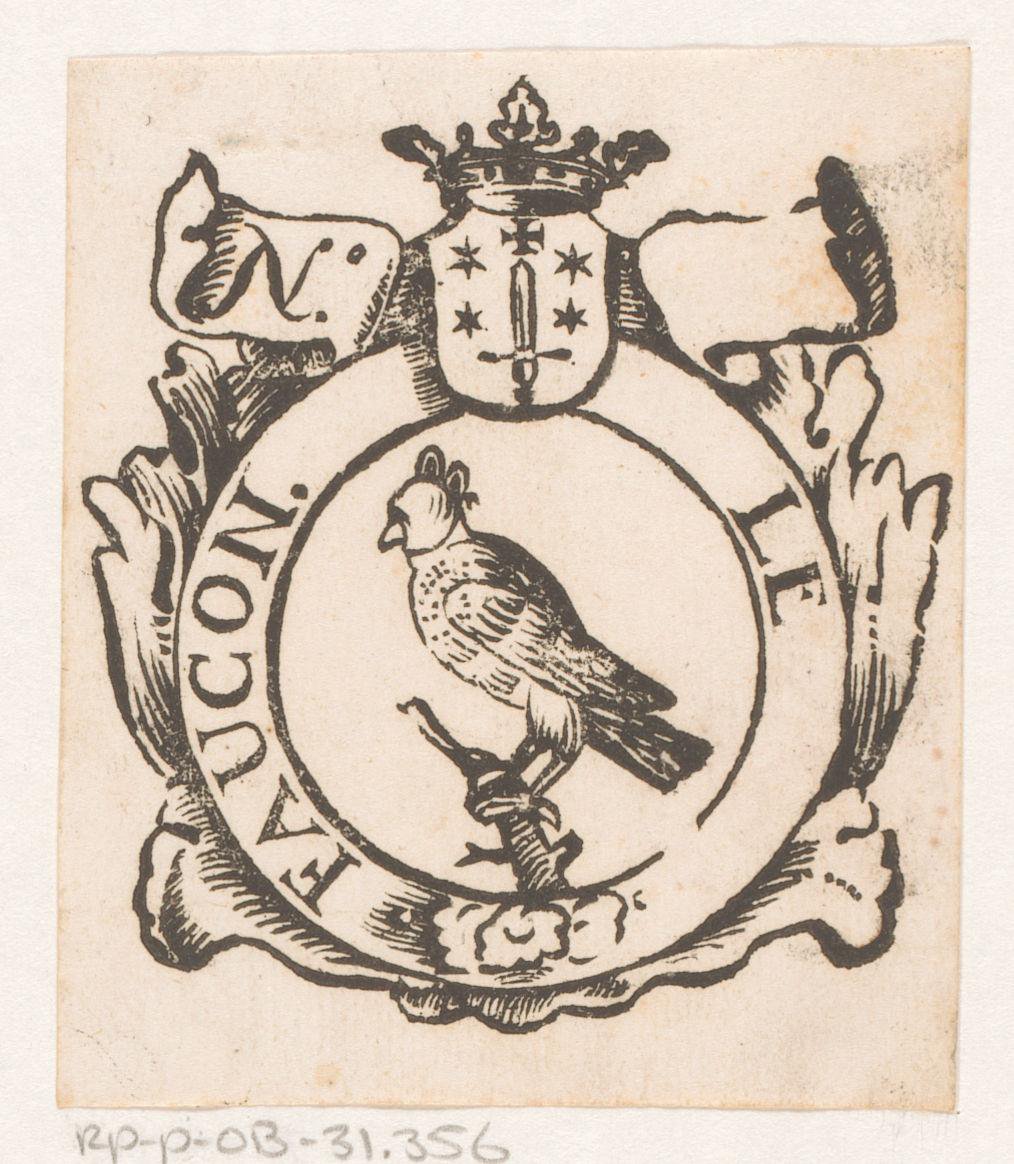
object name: print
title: Vignet met een valk en het wapen van de stad Haarlem met een kroon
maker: Anonymous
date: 1600-1699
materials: paper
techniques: woodcut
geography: netherlands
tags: predatory birds: falcon, coat of arms (as symbol of the state, etc.) (+ city; municipal), vignette, haarlem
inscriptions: collector's mark: Lugt 240